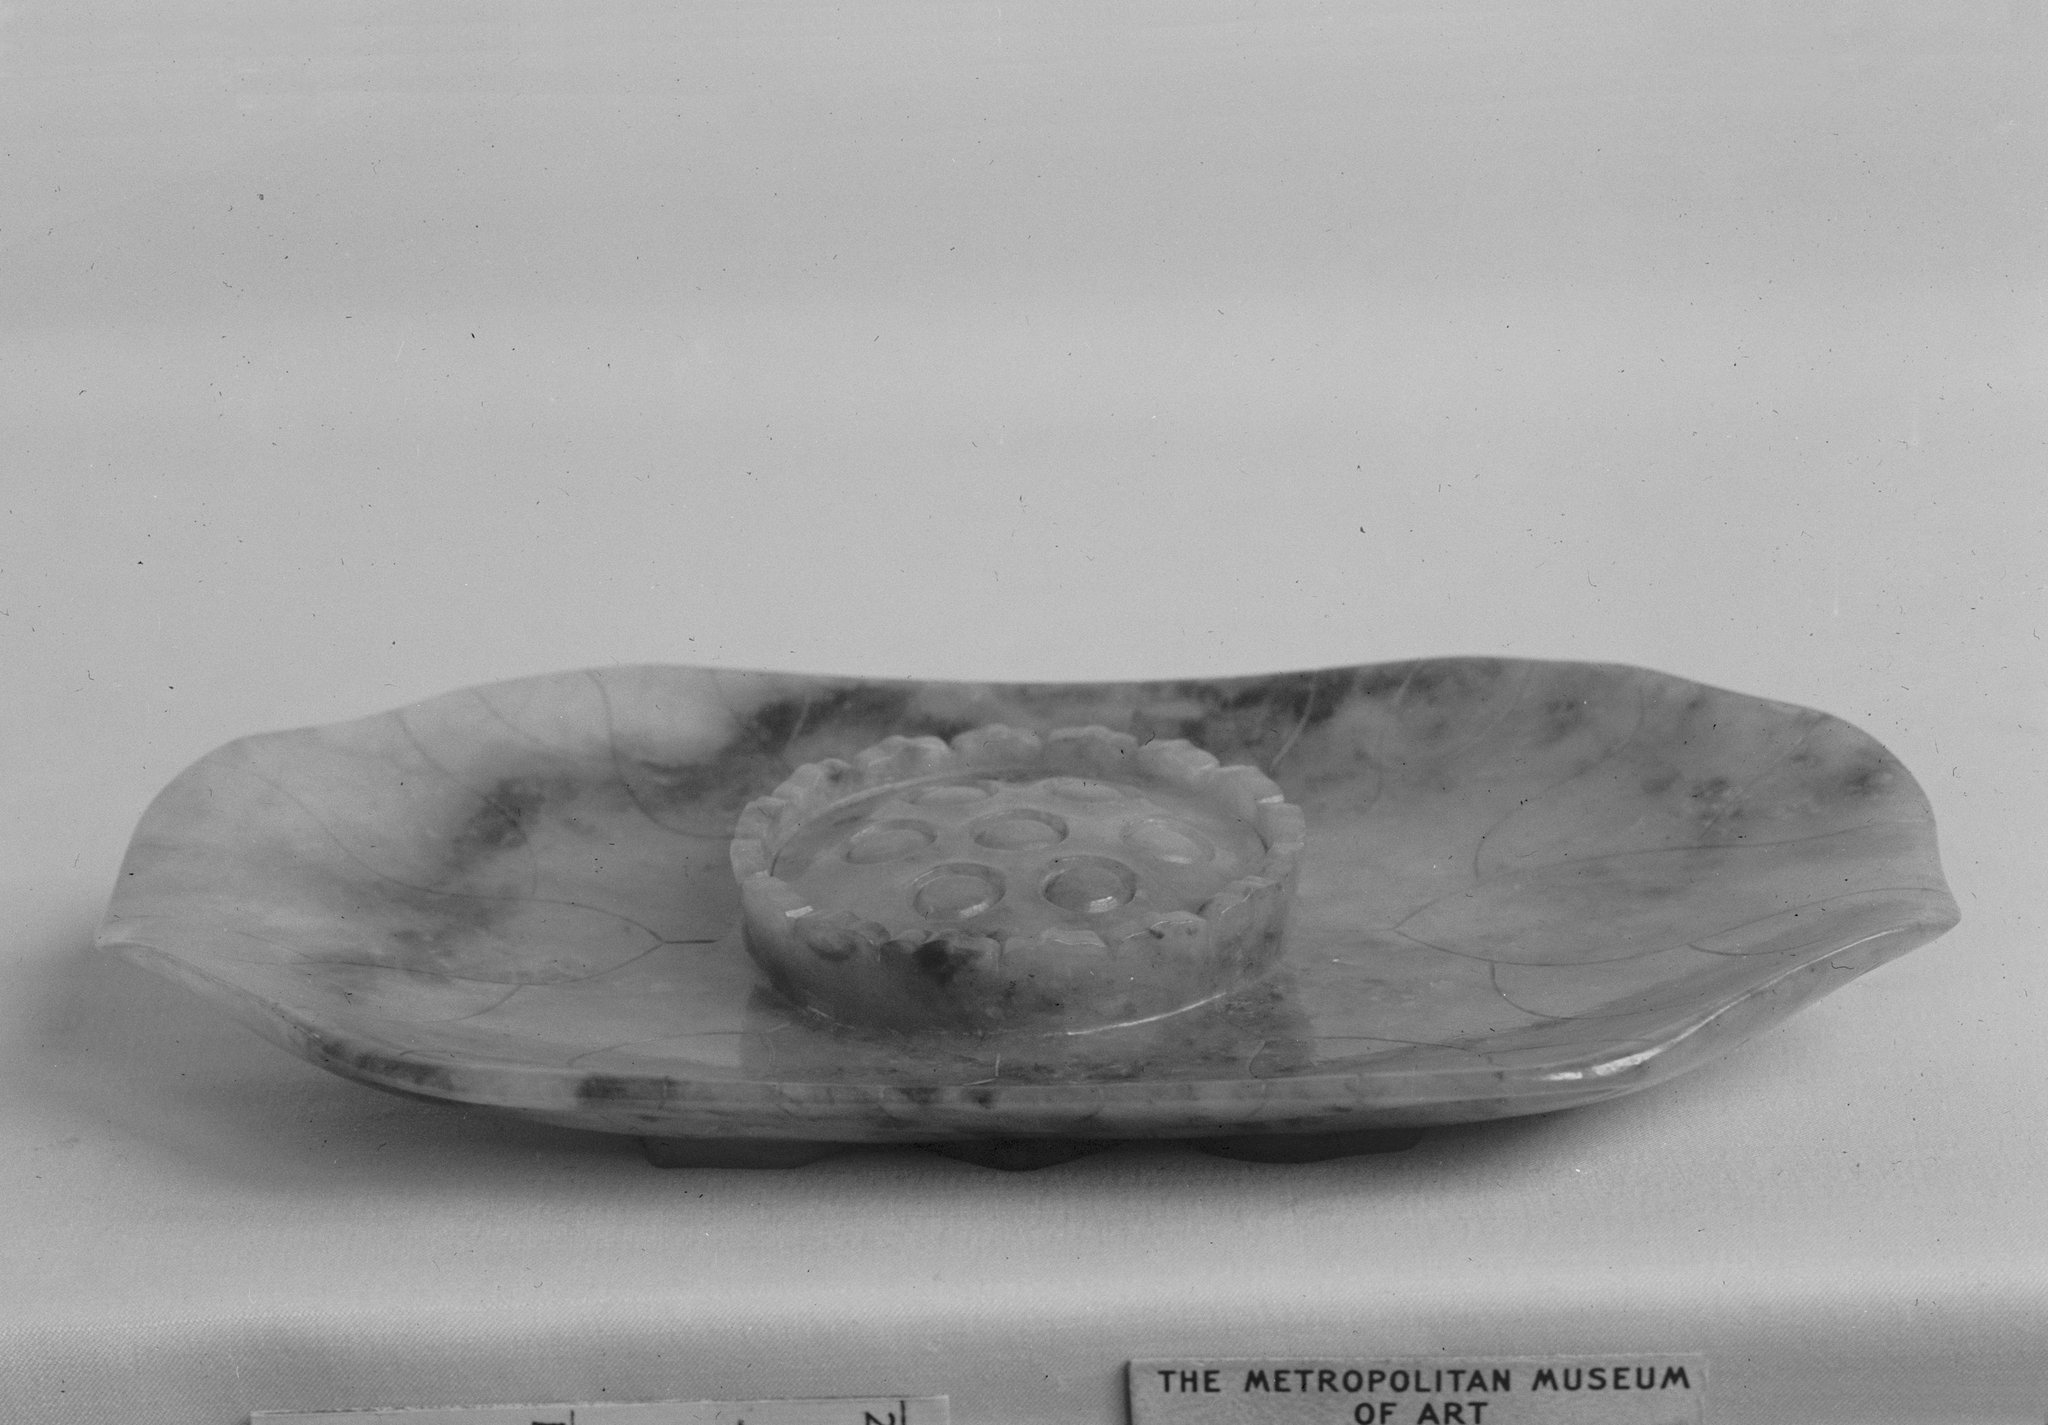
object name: tray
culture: chinese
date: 1368-1644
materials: jade